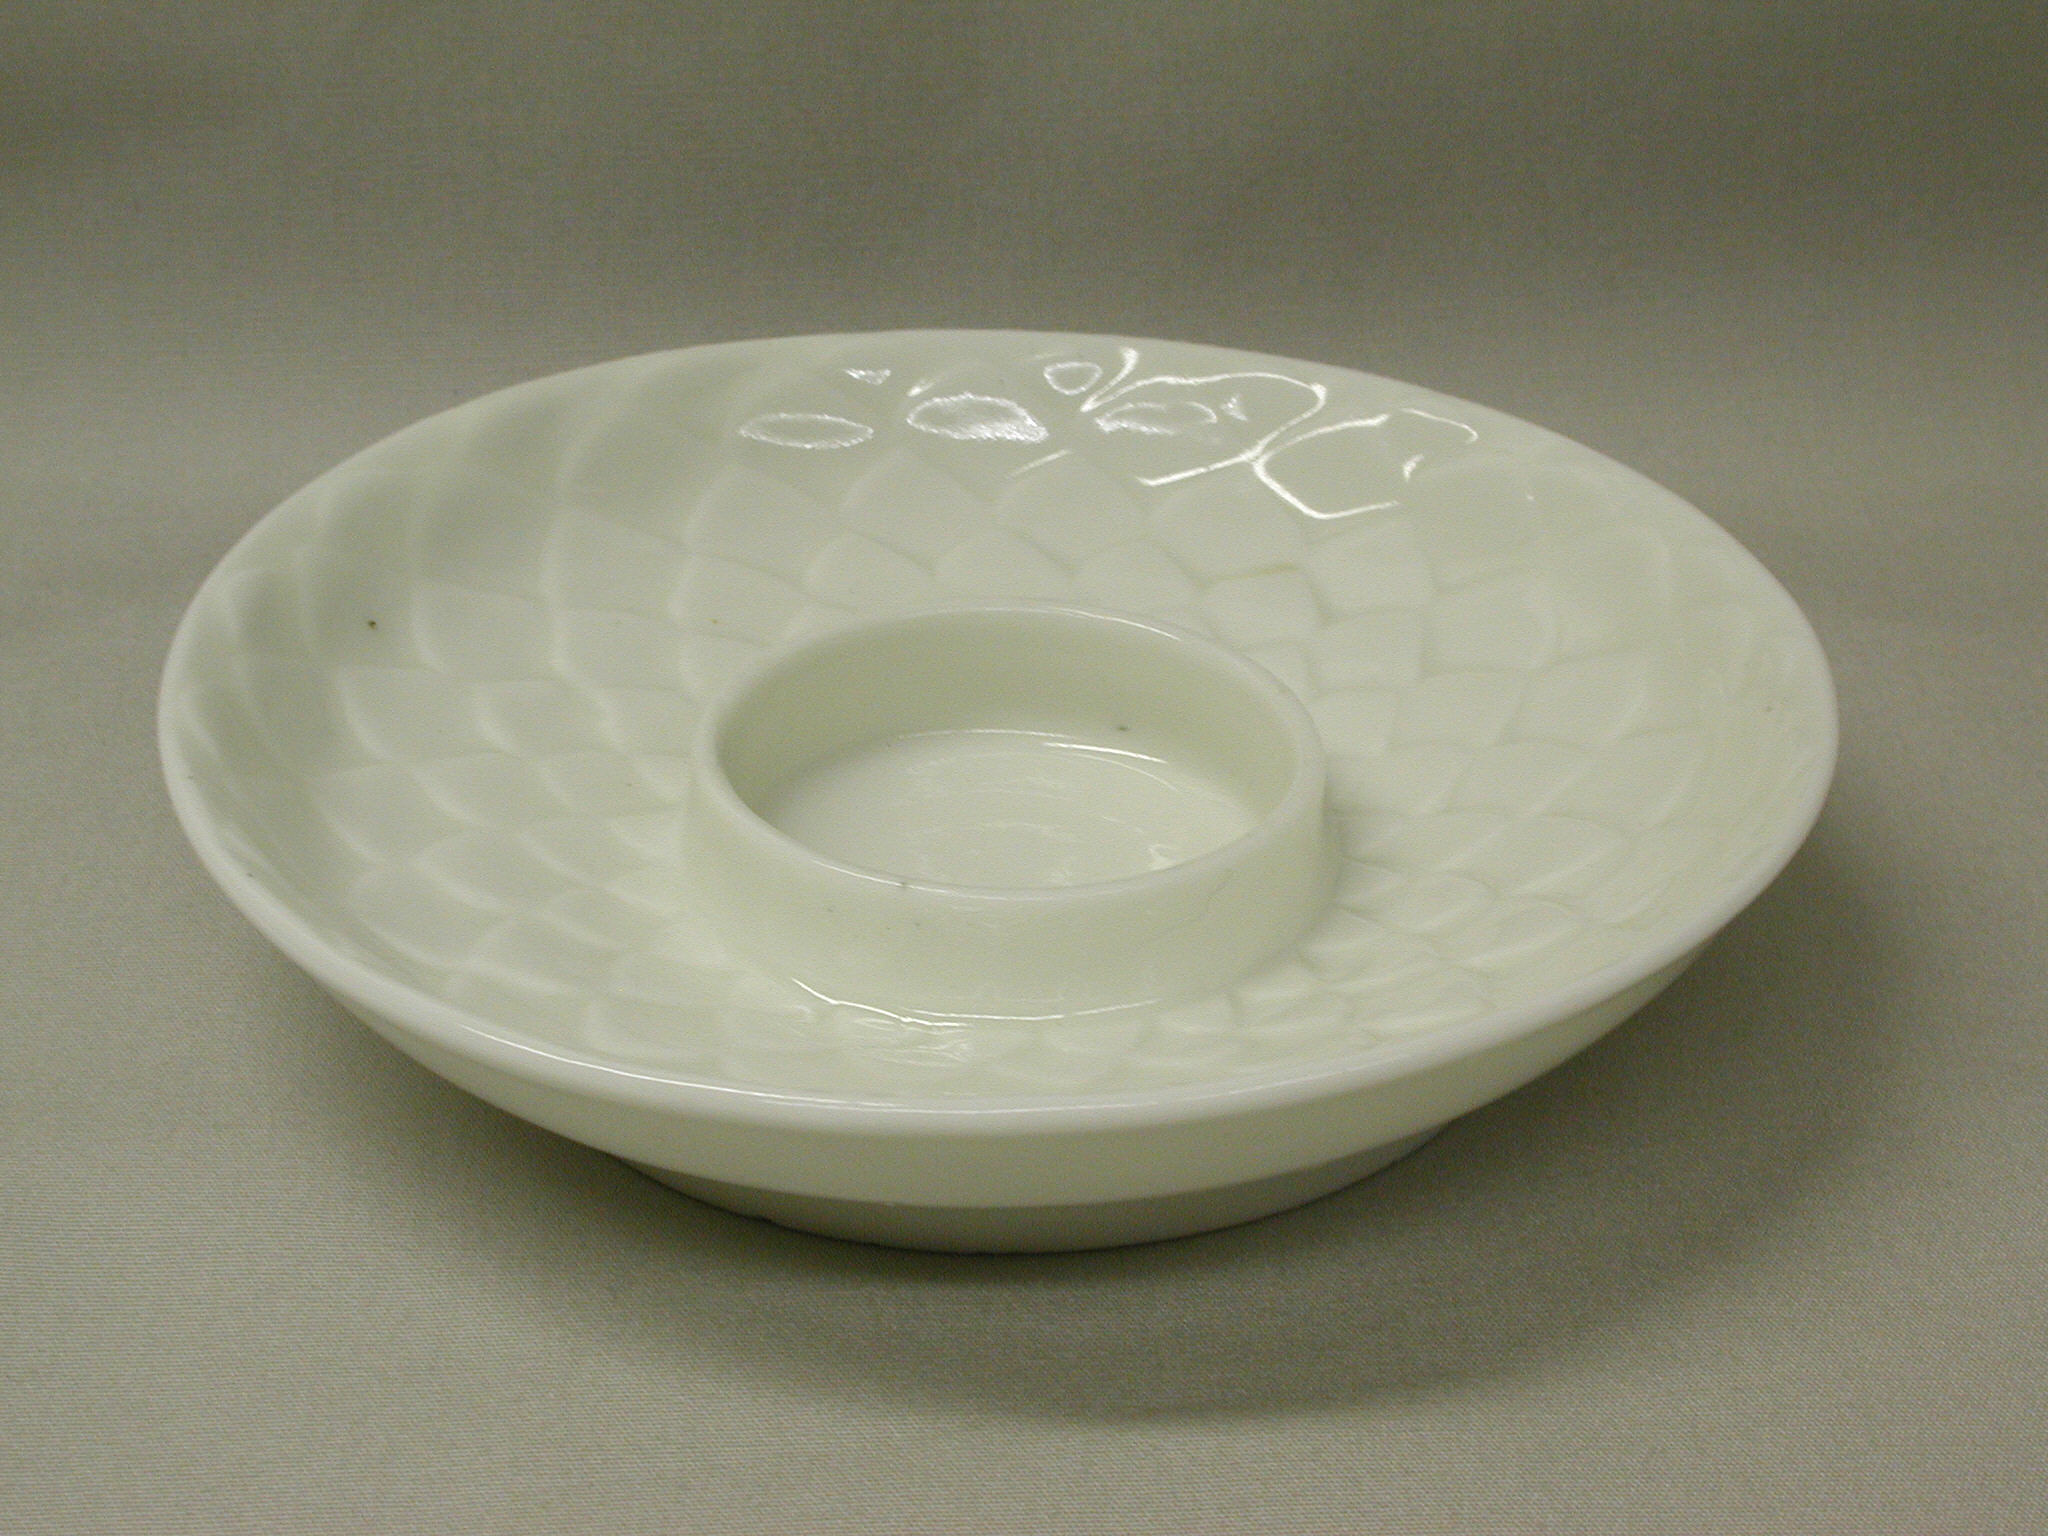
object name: saucer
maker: saint-cloud factory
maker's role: factory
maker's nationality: french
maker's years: 1693-1766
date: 1725-1740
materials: soft paste porcelain